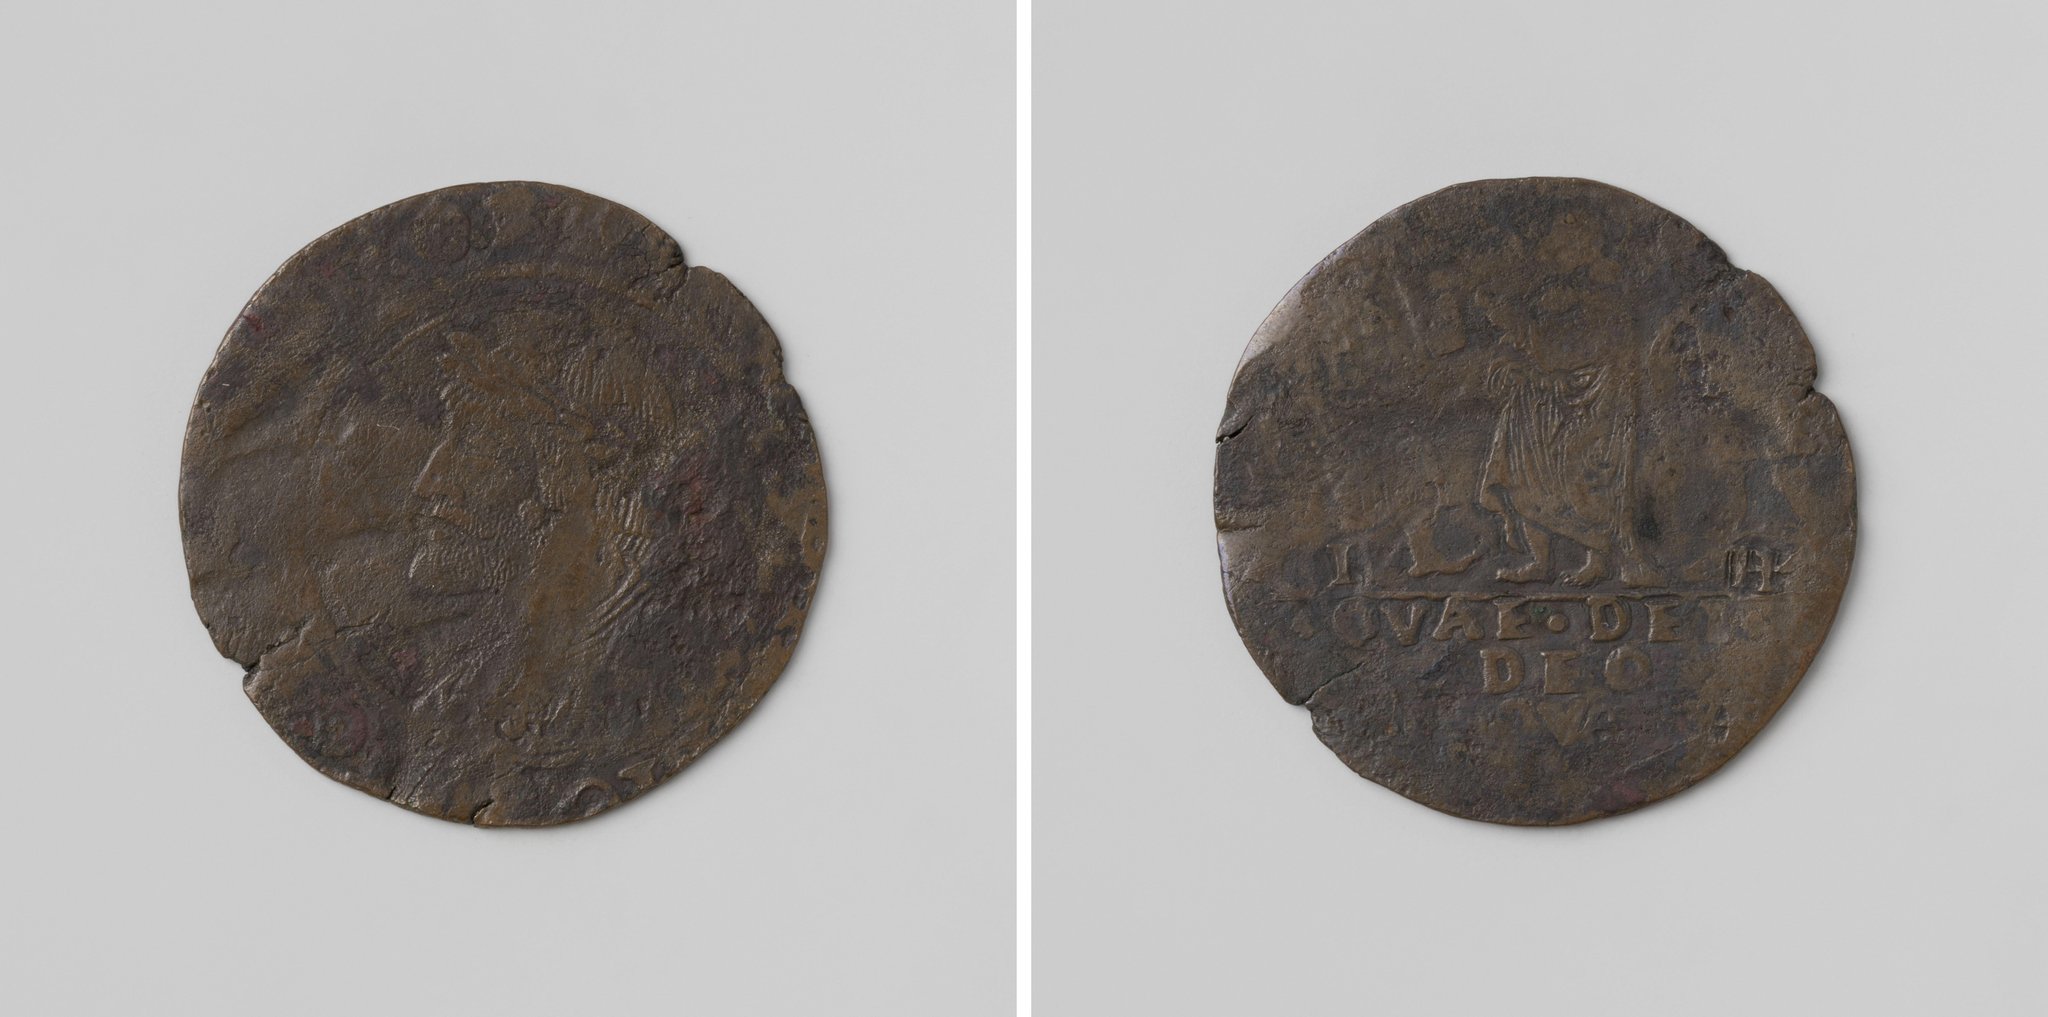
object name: jeton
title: Bevrediging van Gent, rekenpenning geslagen ter ere van Karel V, Duits keizer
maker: Anonymous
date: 1540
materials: copper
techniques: striking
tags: ghent, charles v (holy roman emperor and king of spain)